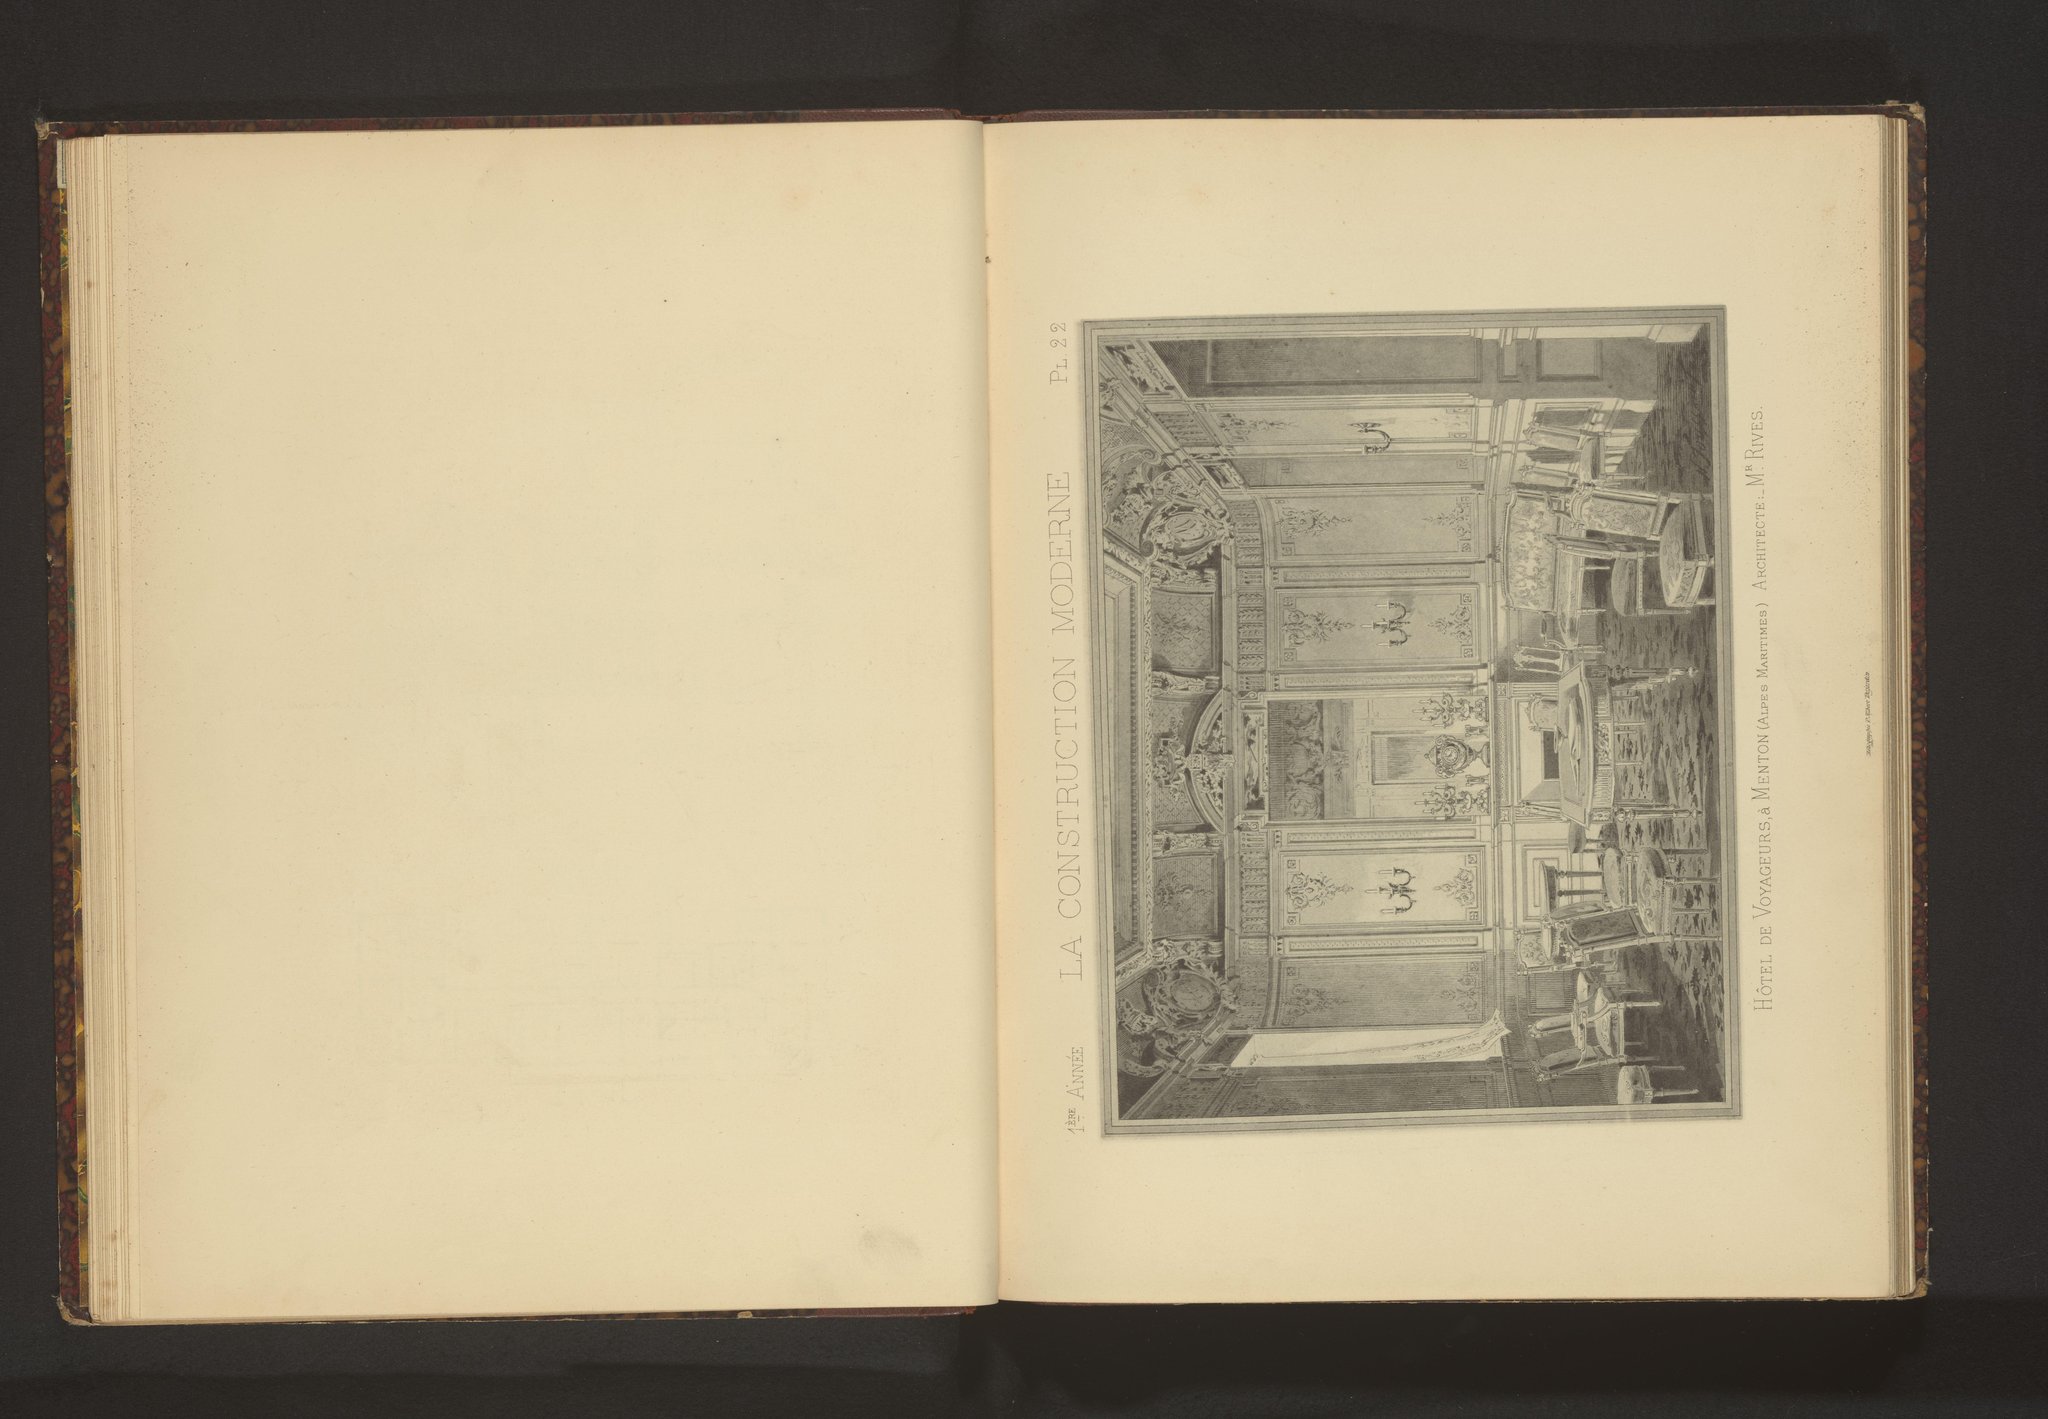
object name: photomechanical print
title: Reproductie van een prent van een zitkamer in een hotel in Menton door H. Toussaint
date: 1881-1886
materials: paper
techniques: photograph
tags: living-room, parlour, sitting-room, hotel, hostelry, inn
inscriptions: inscription: ‘Architecte: Mr. Rives.’, inscription: ‘1ère Année: LA CONSTRUCTION MODERNE Pl. 22’